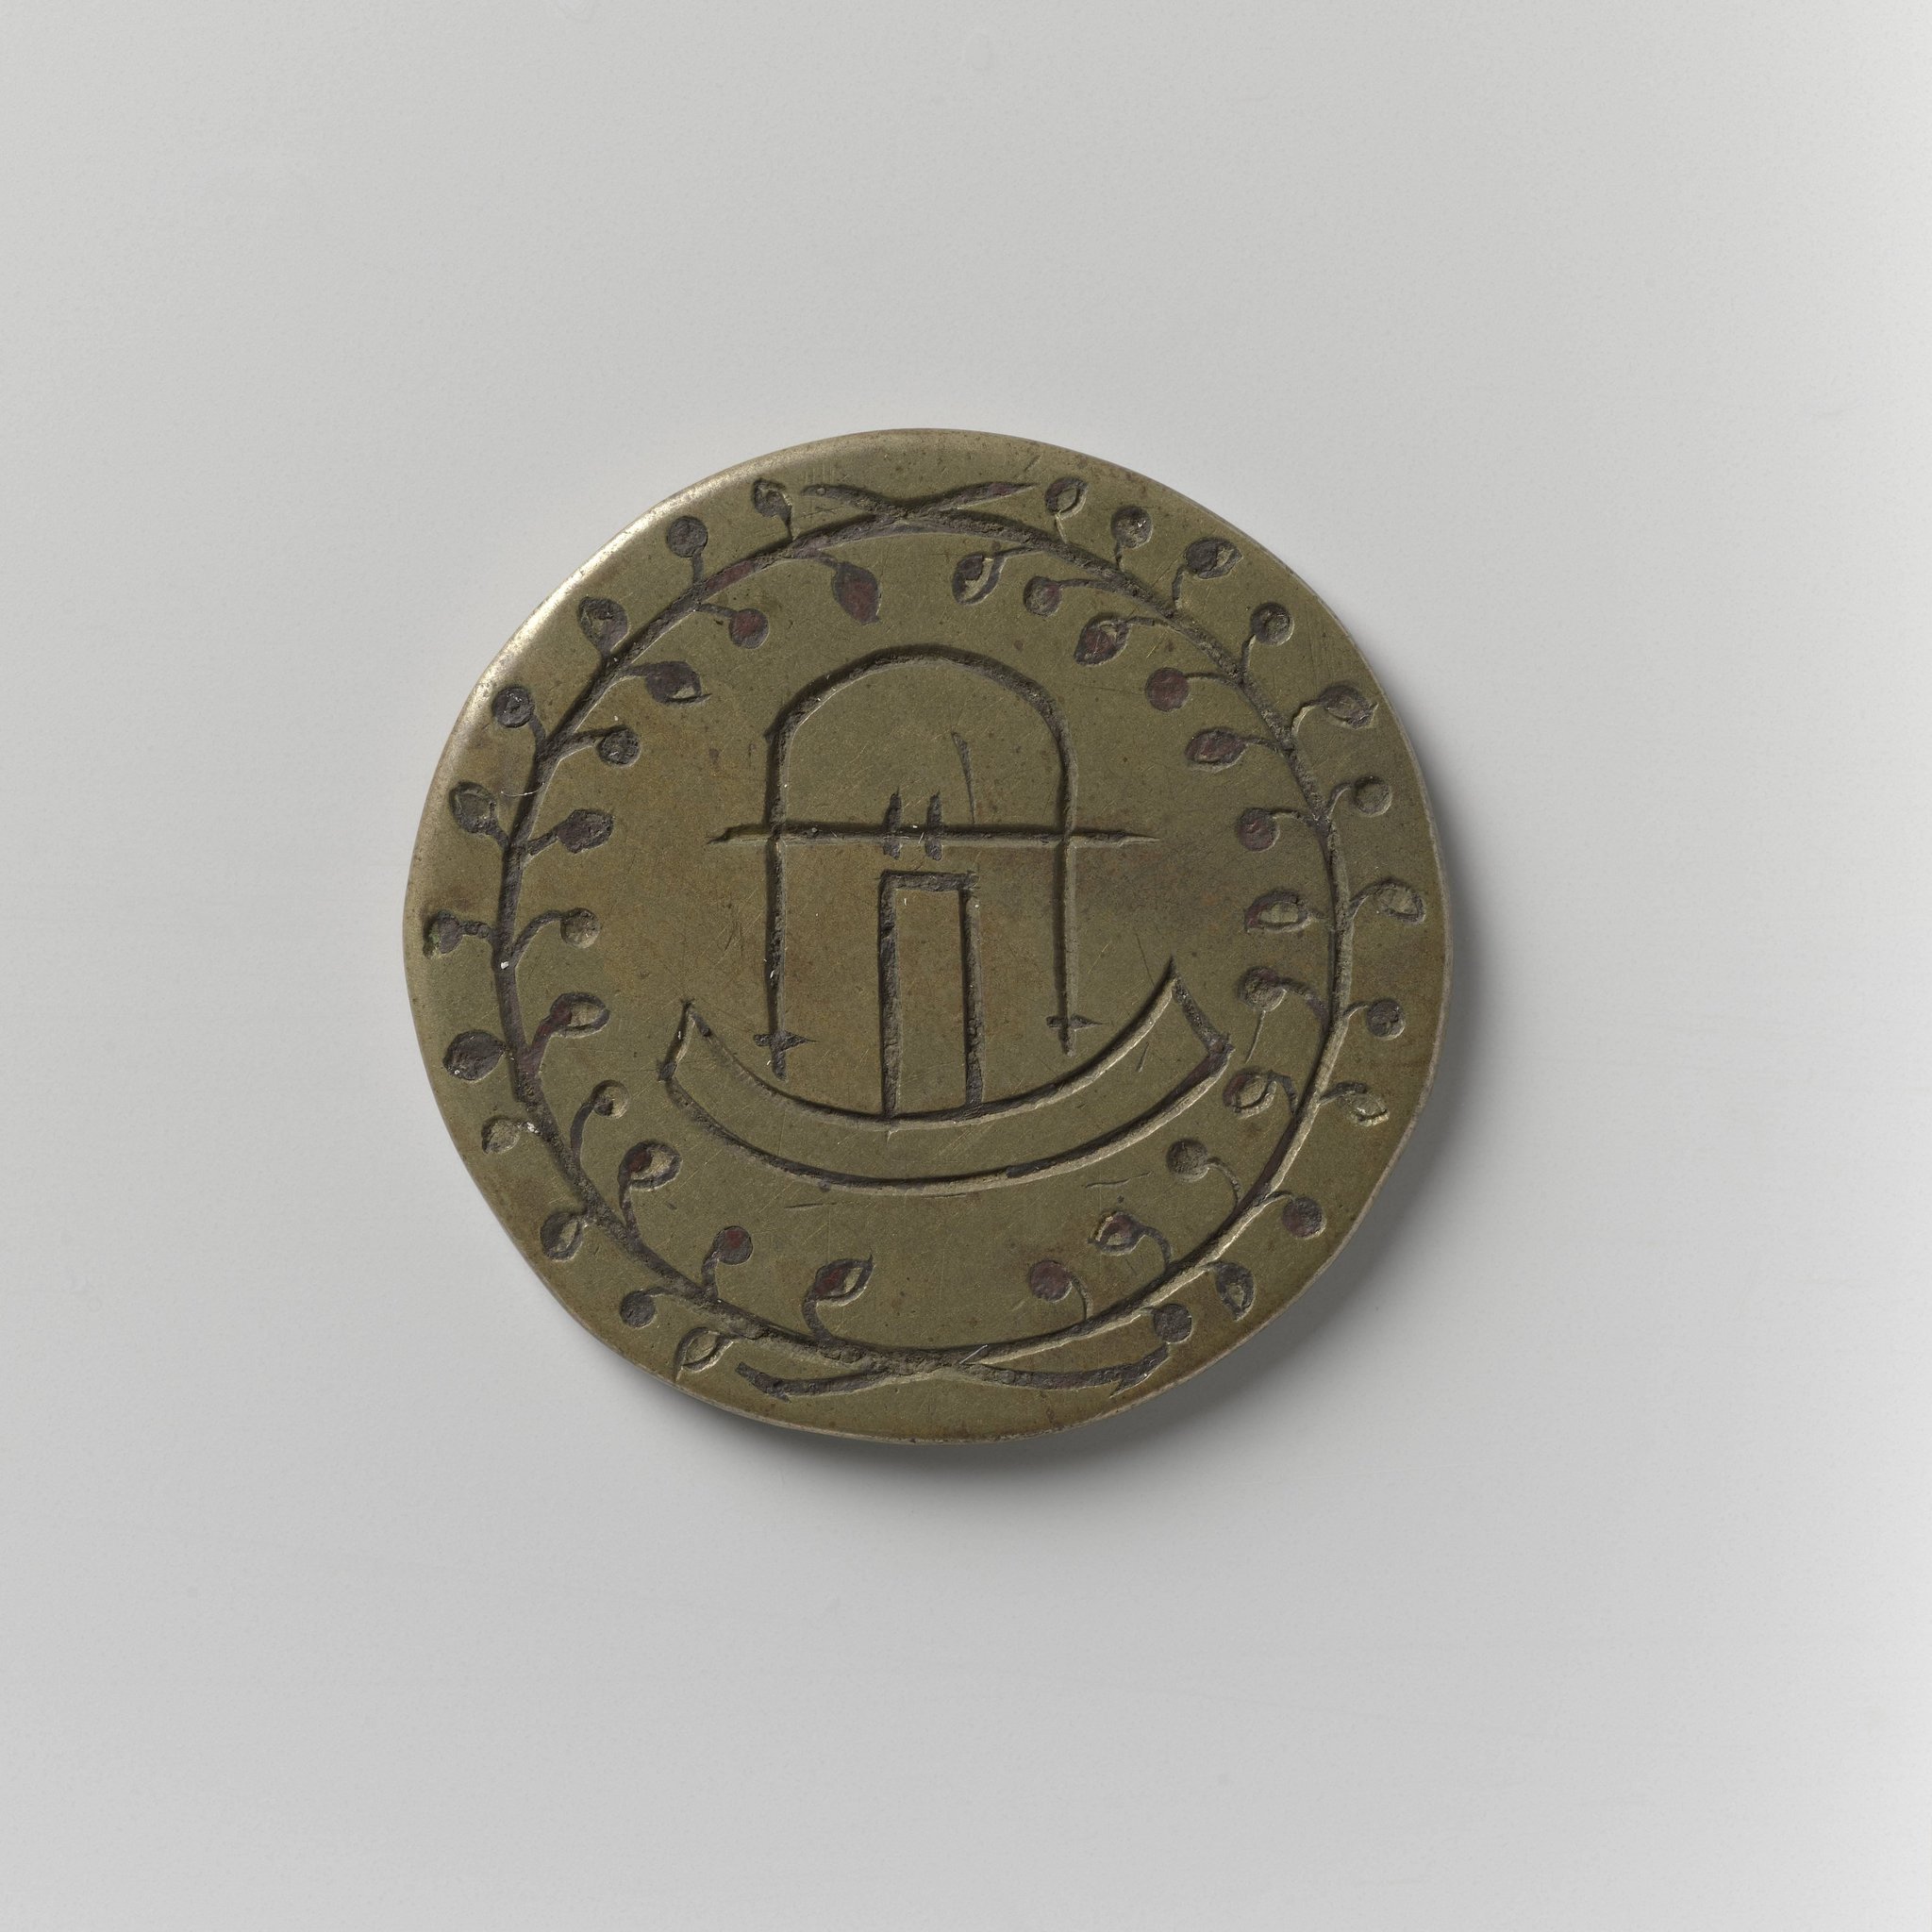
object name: medal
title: Kuipers- en wijnverlatersgilde van Amsterdam, gildepenning van Marten ten Hove, meester kuiper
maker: Anonymous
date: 1703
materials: brass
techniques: engraving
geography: amsterdam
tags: amsterdam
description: Messing penning. Voorzijde: gestileerde dissel en passer binnen bladerkrans. Keerzijde: opschrift